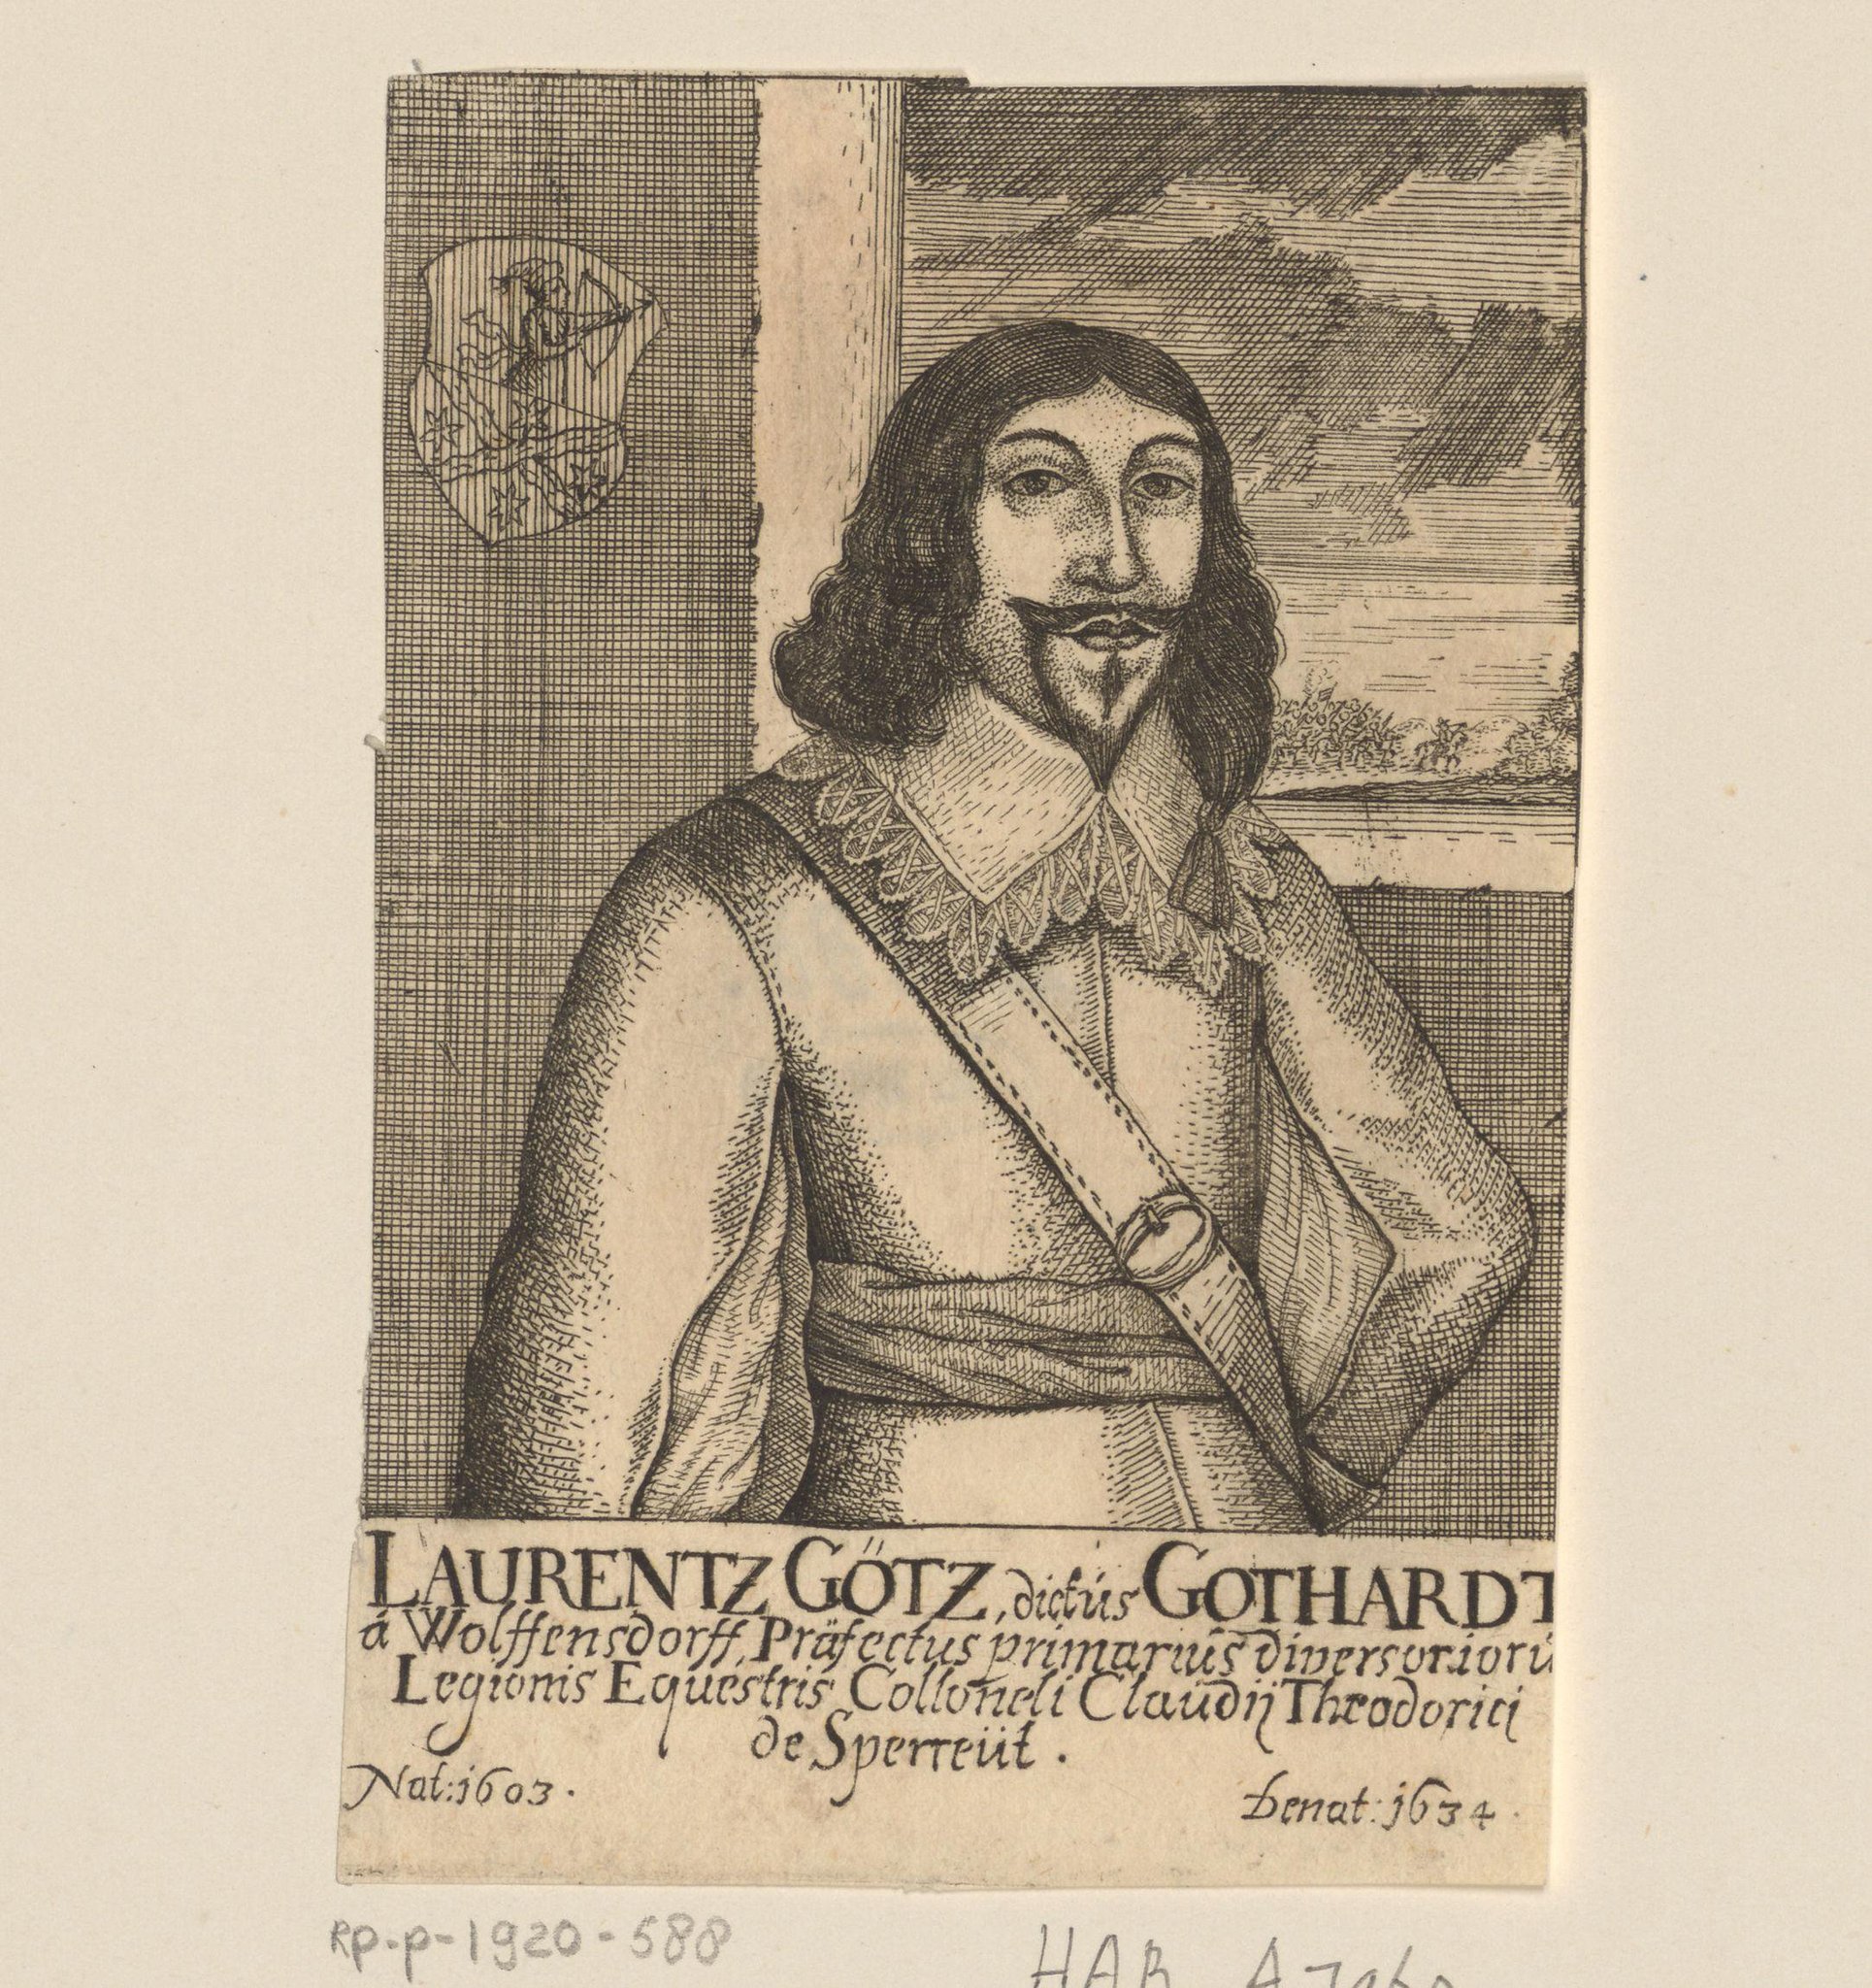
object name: print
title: Portret van Laurentz Götz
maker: johann reinhold mühl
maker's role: print maker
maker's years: 1631-1692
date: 1641-1692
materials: paper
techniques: engraving, etching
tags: historical persons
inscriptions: collector's mark: Lugt 2228